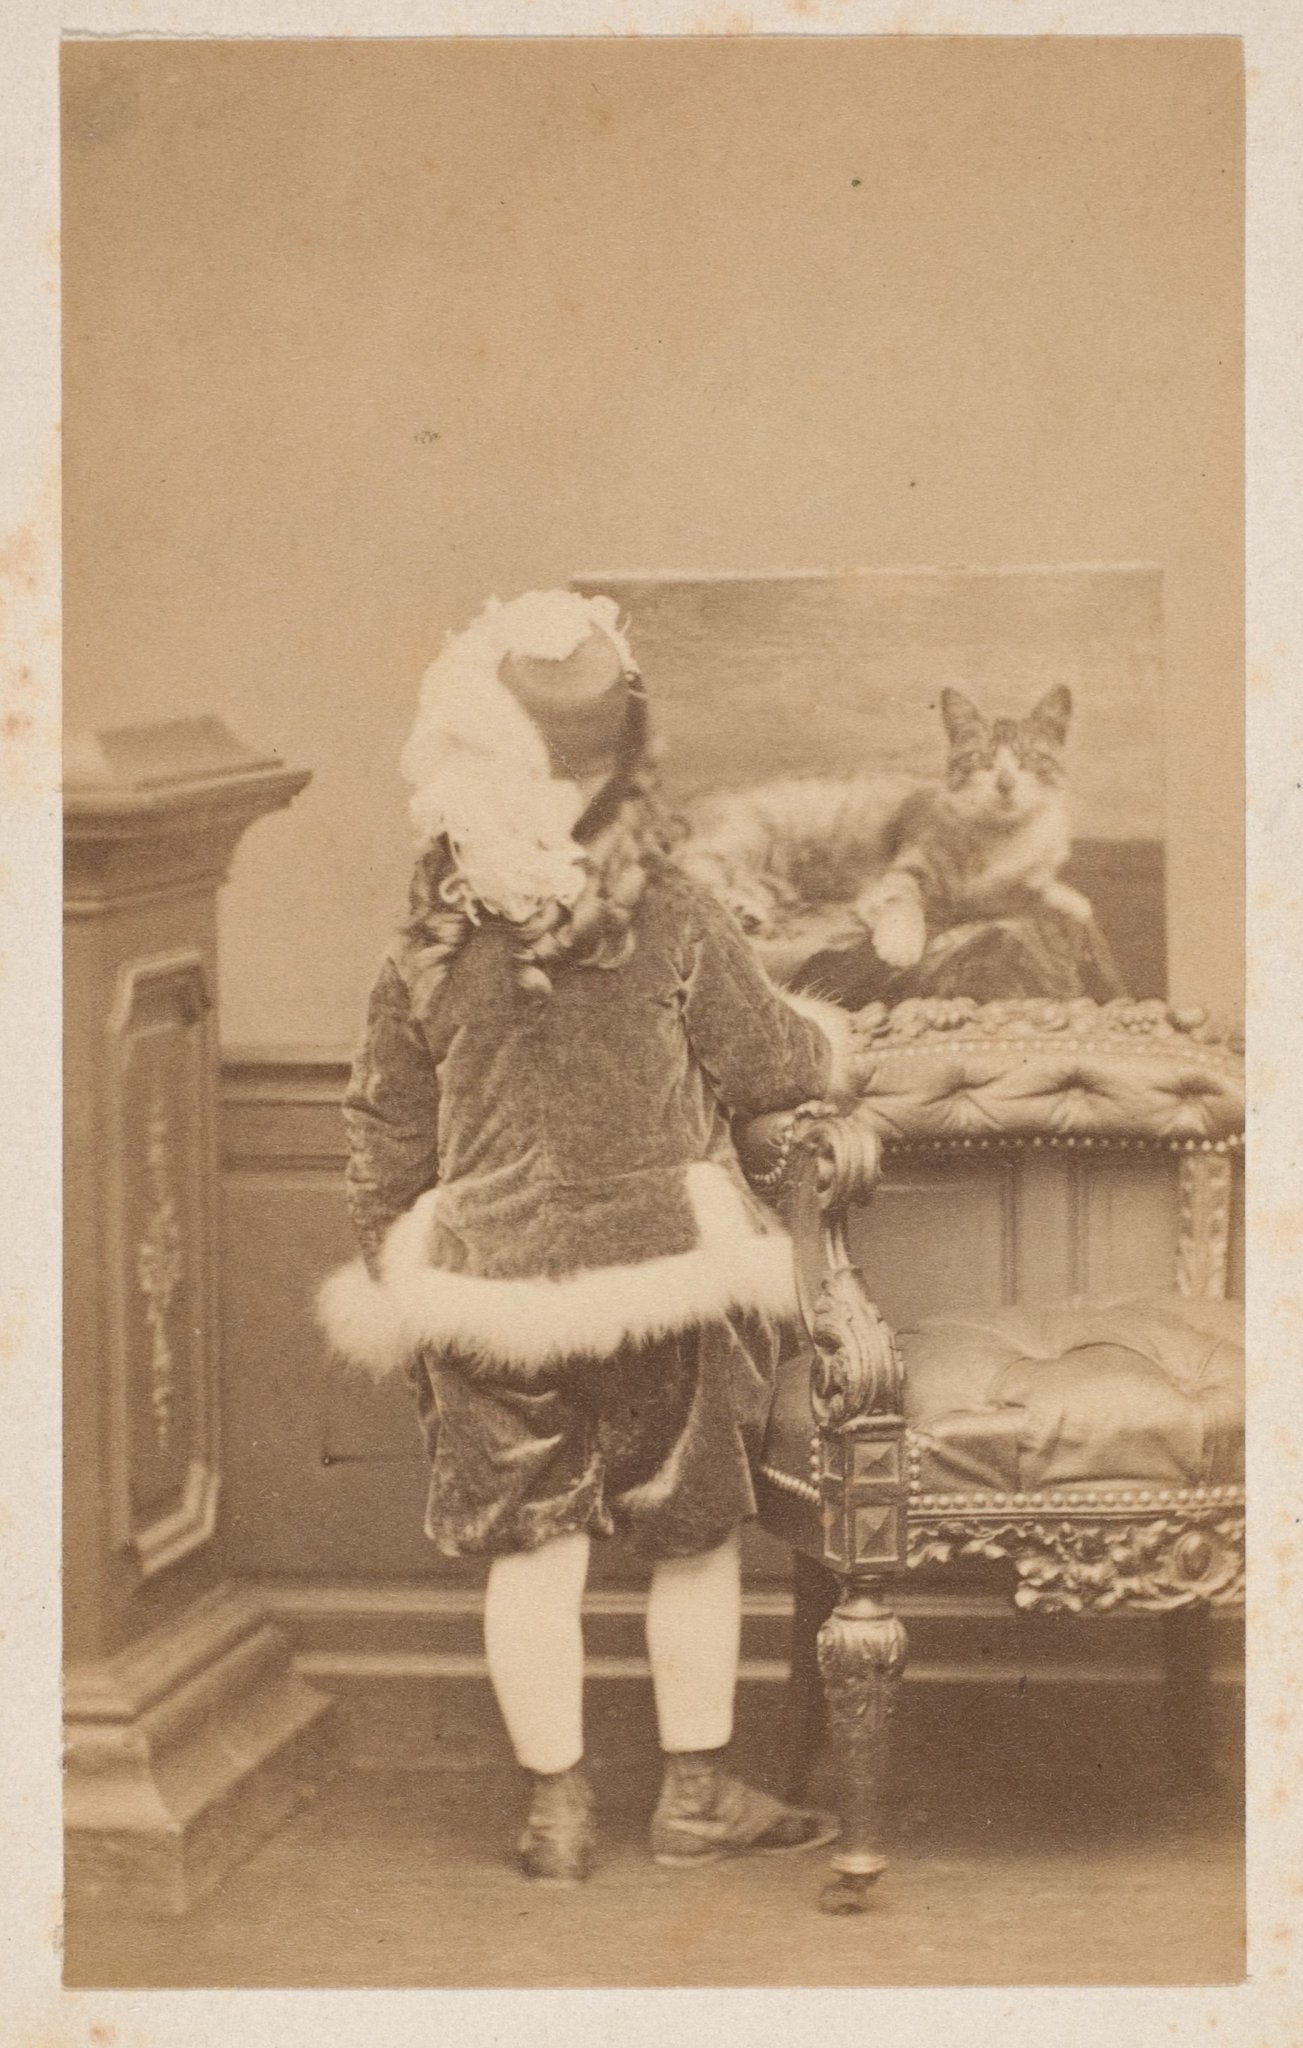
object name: photograph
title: La veste de cygne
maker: pierre-louis pierson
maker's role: artist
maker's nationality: french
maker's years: 1822-1913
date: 1860-1869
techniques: albumen silver print, glass negative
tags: children,portraits,cats,chairs